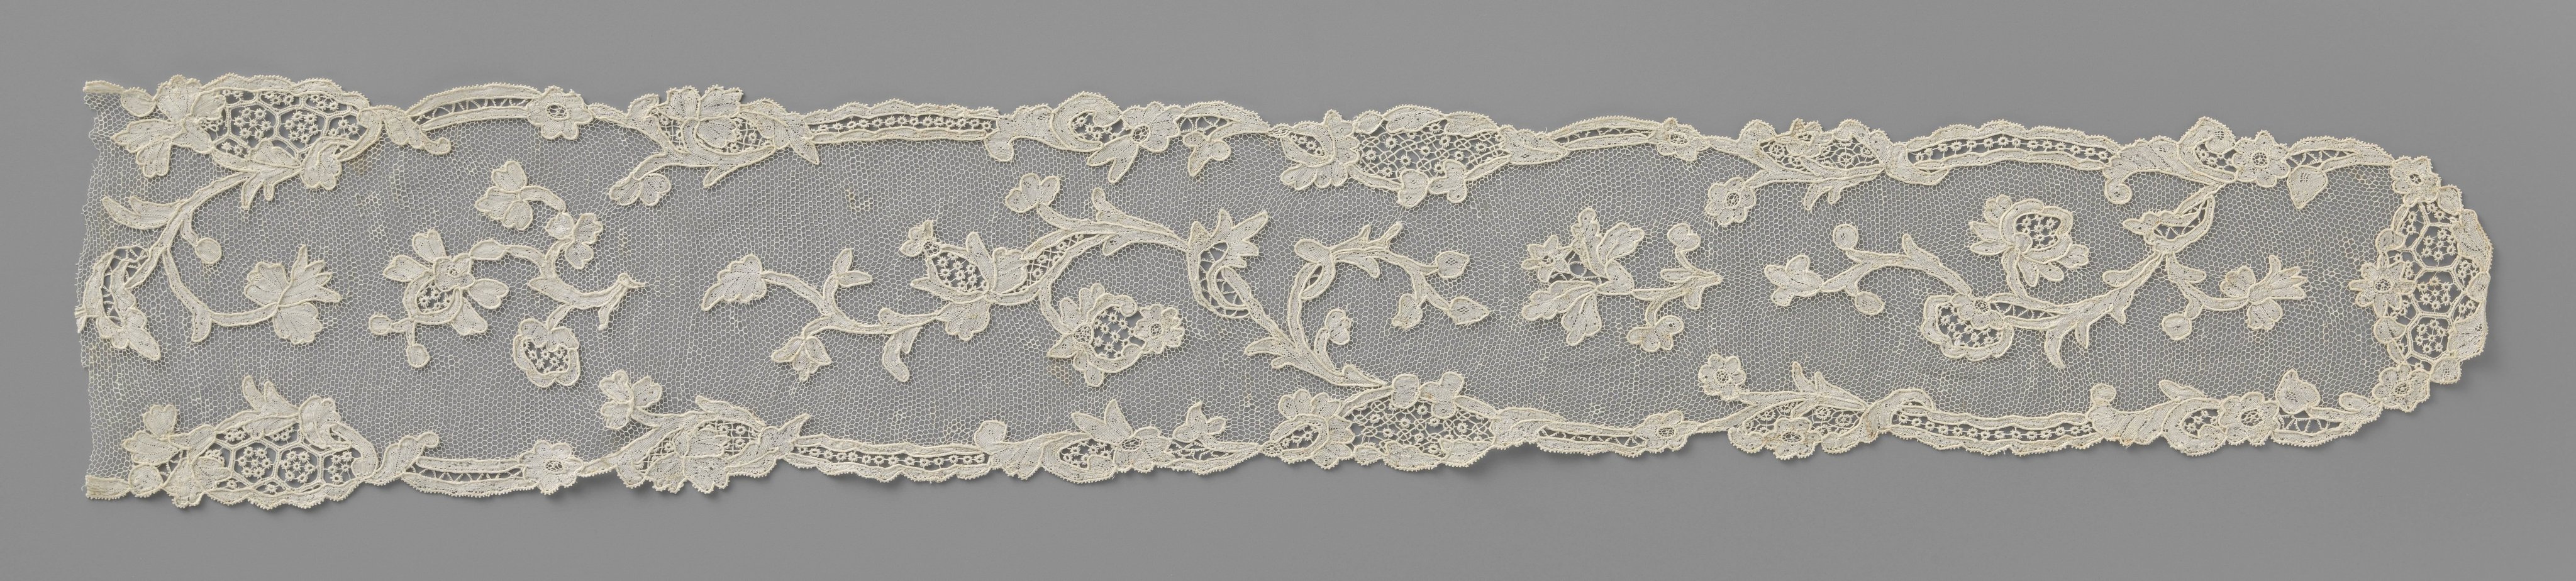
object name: lappet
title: Mutsenslip van naaldkant met hangende bloemen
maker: Anonymous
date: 1760-1790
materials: linen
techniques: lace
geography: france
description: Langgerekte schulpen van een golvend lintje, afgewisseld door medaillons met rasterwerk, vormen de buitenranden van een grond, waarop beurtelings een golvende tak met hangende bloemen en granaatappels en een kort bloemtakje staan. In de strook is het patroon symmetrisch ten opzichte van een staande middentak. Alençon-kant.